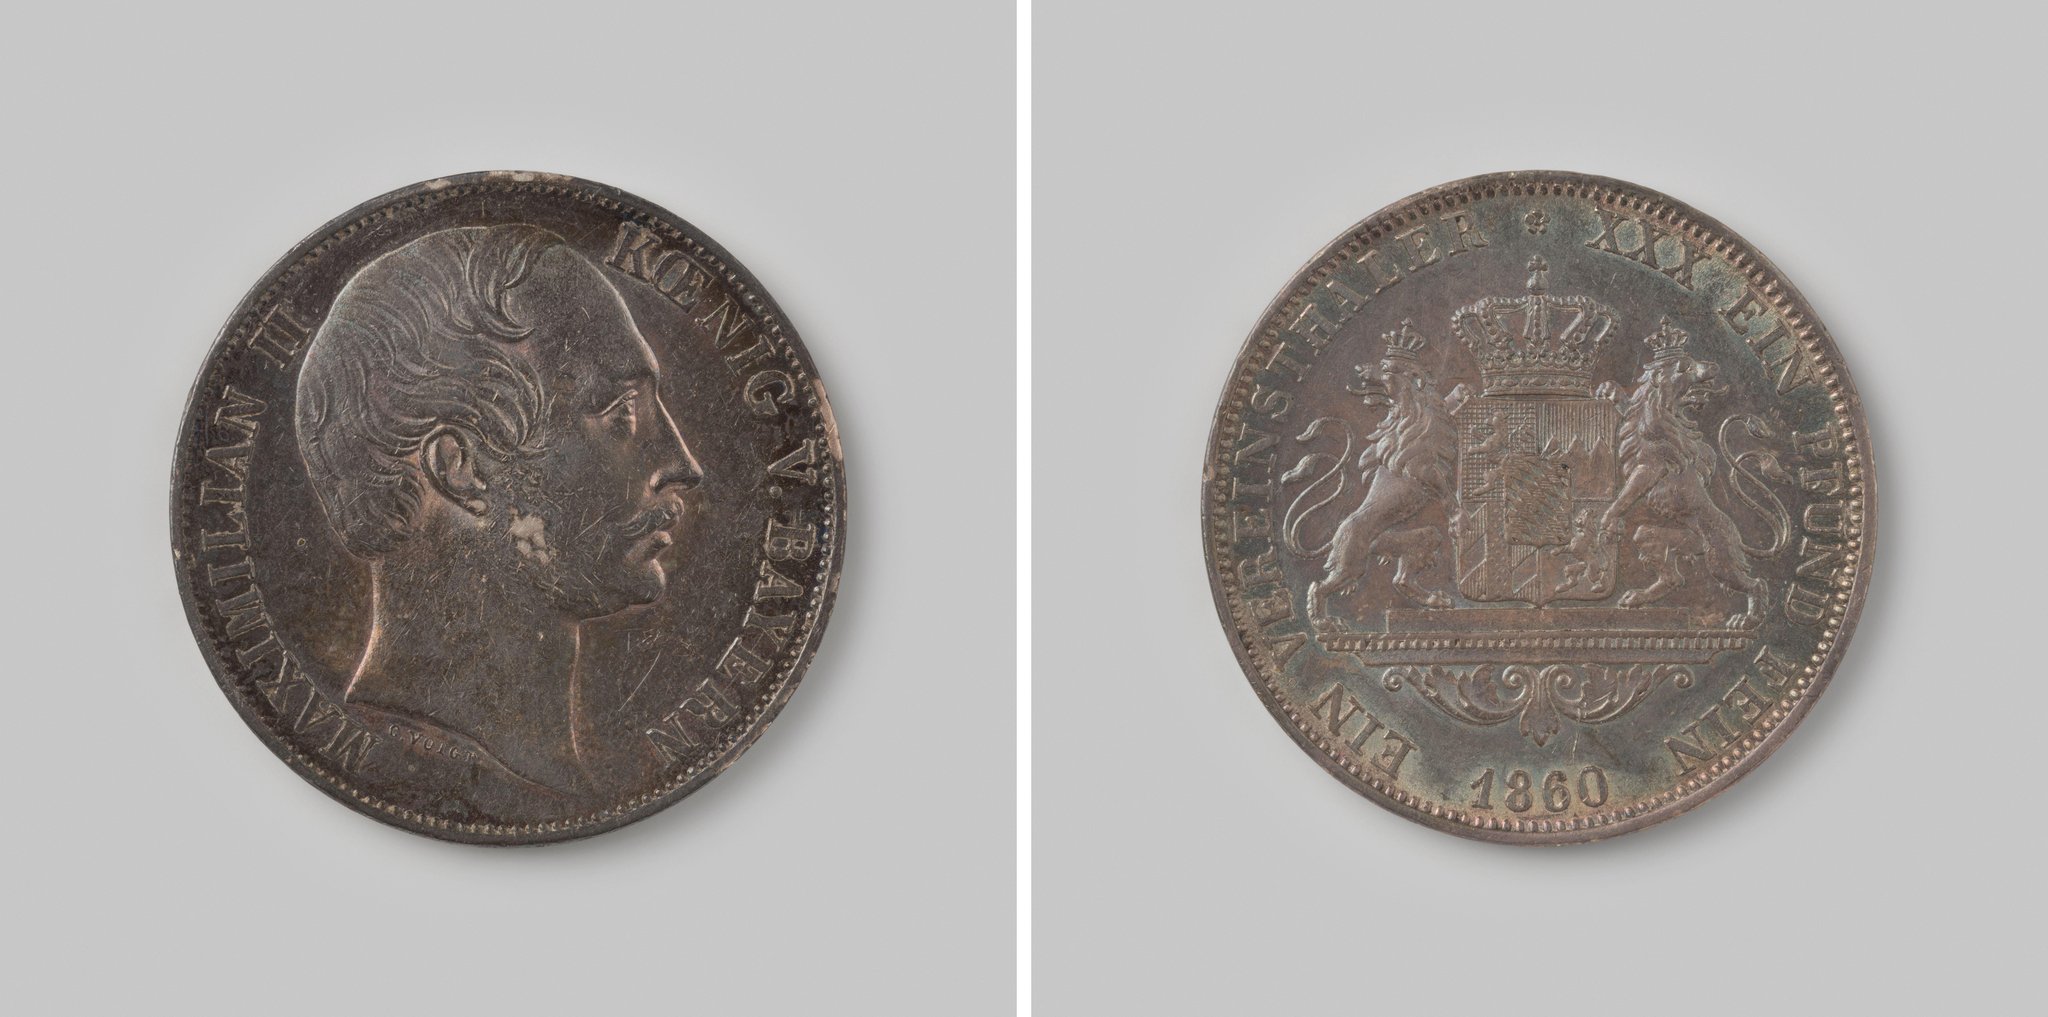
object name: coin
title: Koninkrijk Beieren, vereinsthaler, Maximilian II, 1860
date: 1860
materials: silver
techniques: striking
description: Zilveren munt. Voorzijde: borstbeeld van de koning naar rechts. Keerzijde: door twee gekroonde leeuwen gehouden gekroond wapenschild. Waarde-aanduiding: Ein Vereinsthaler in omschrift, jaartal onderaan. Randschrift.